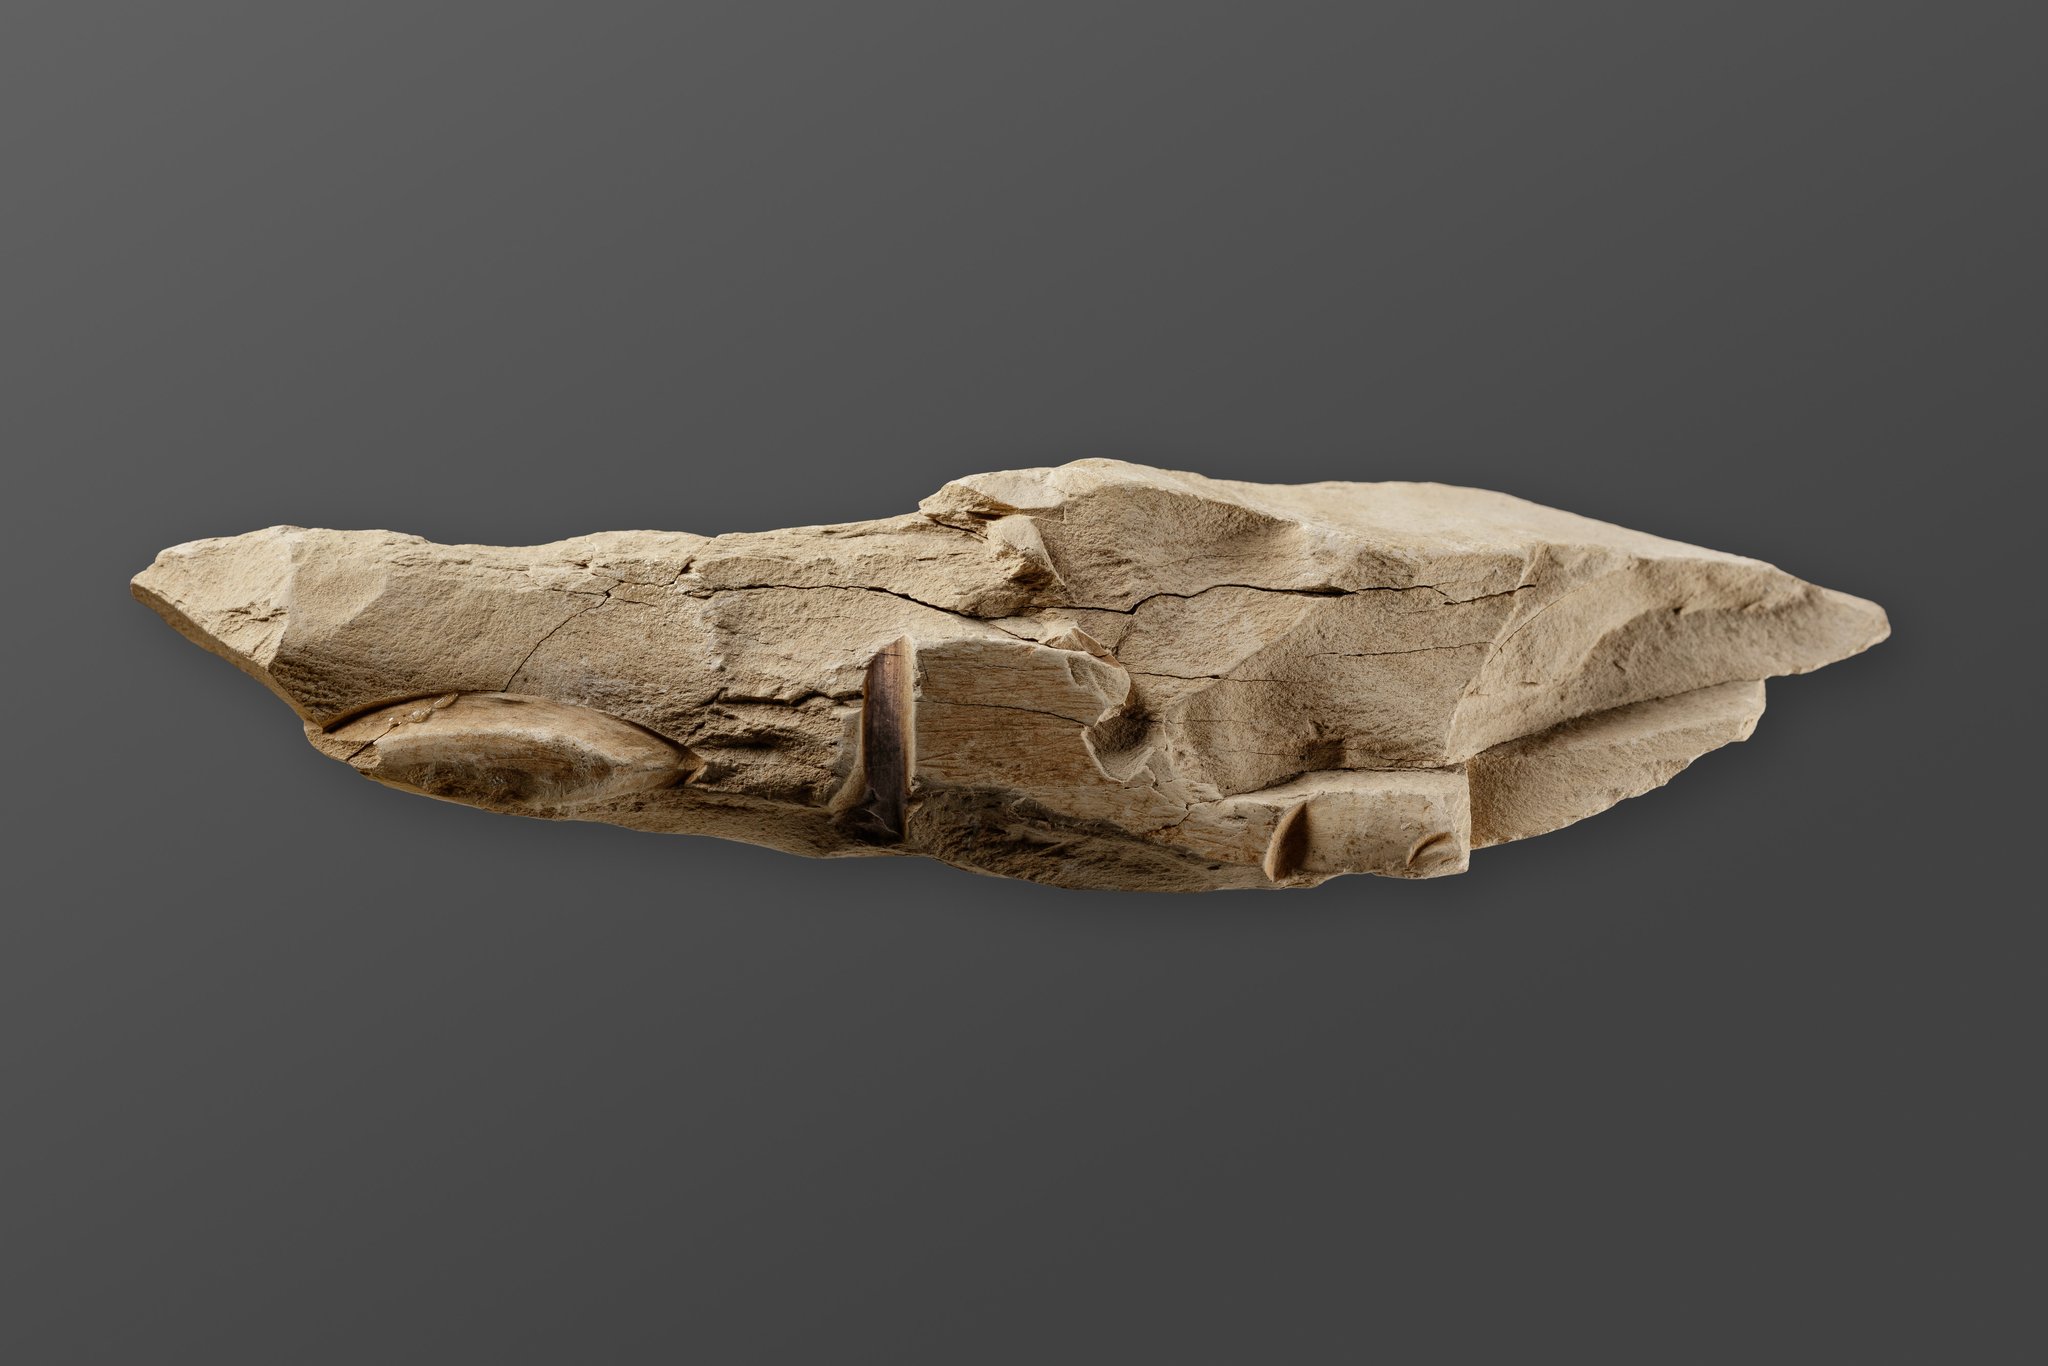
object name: relief fragment 47, tomb of mereri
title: Relief fragment possibly from the tomb of Mereri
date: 2100-2090 BCE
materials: stone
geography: egypt